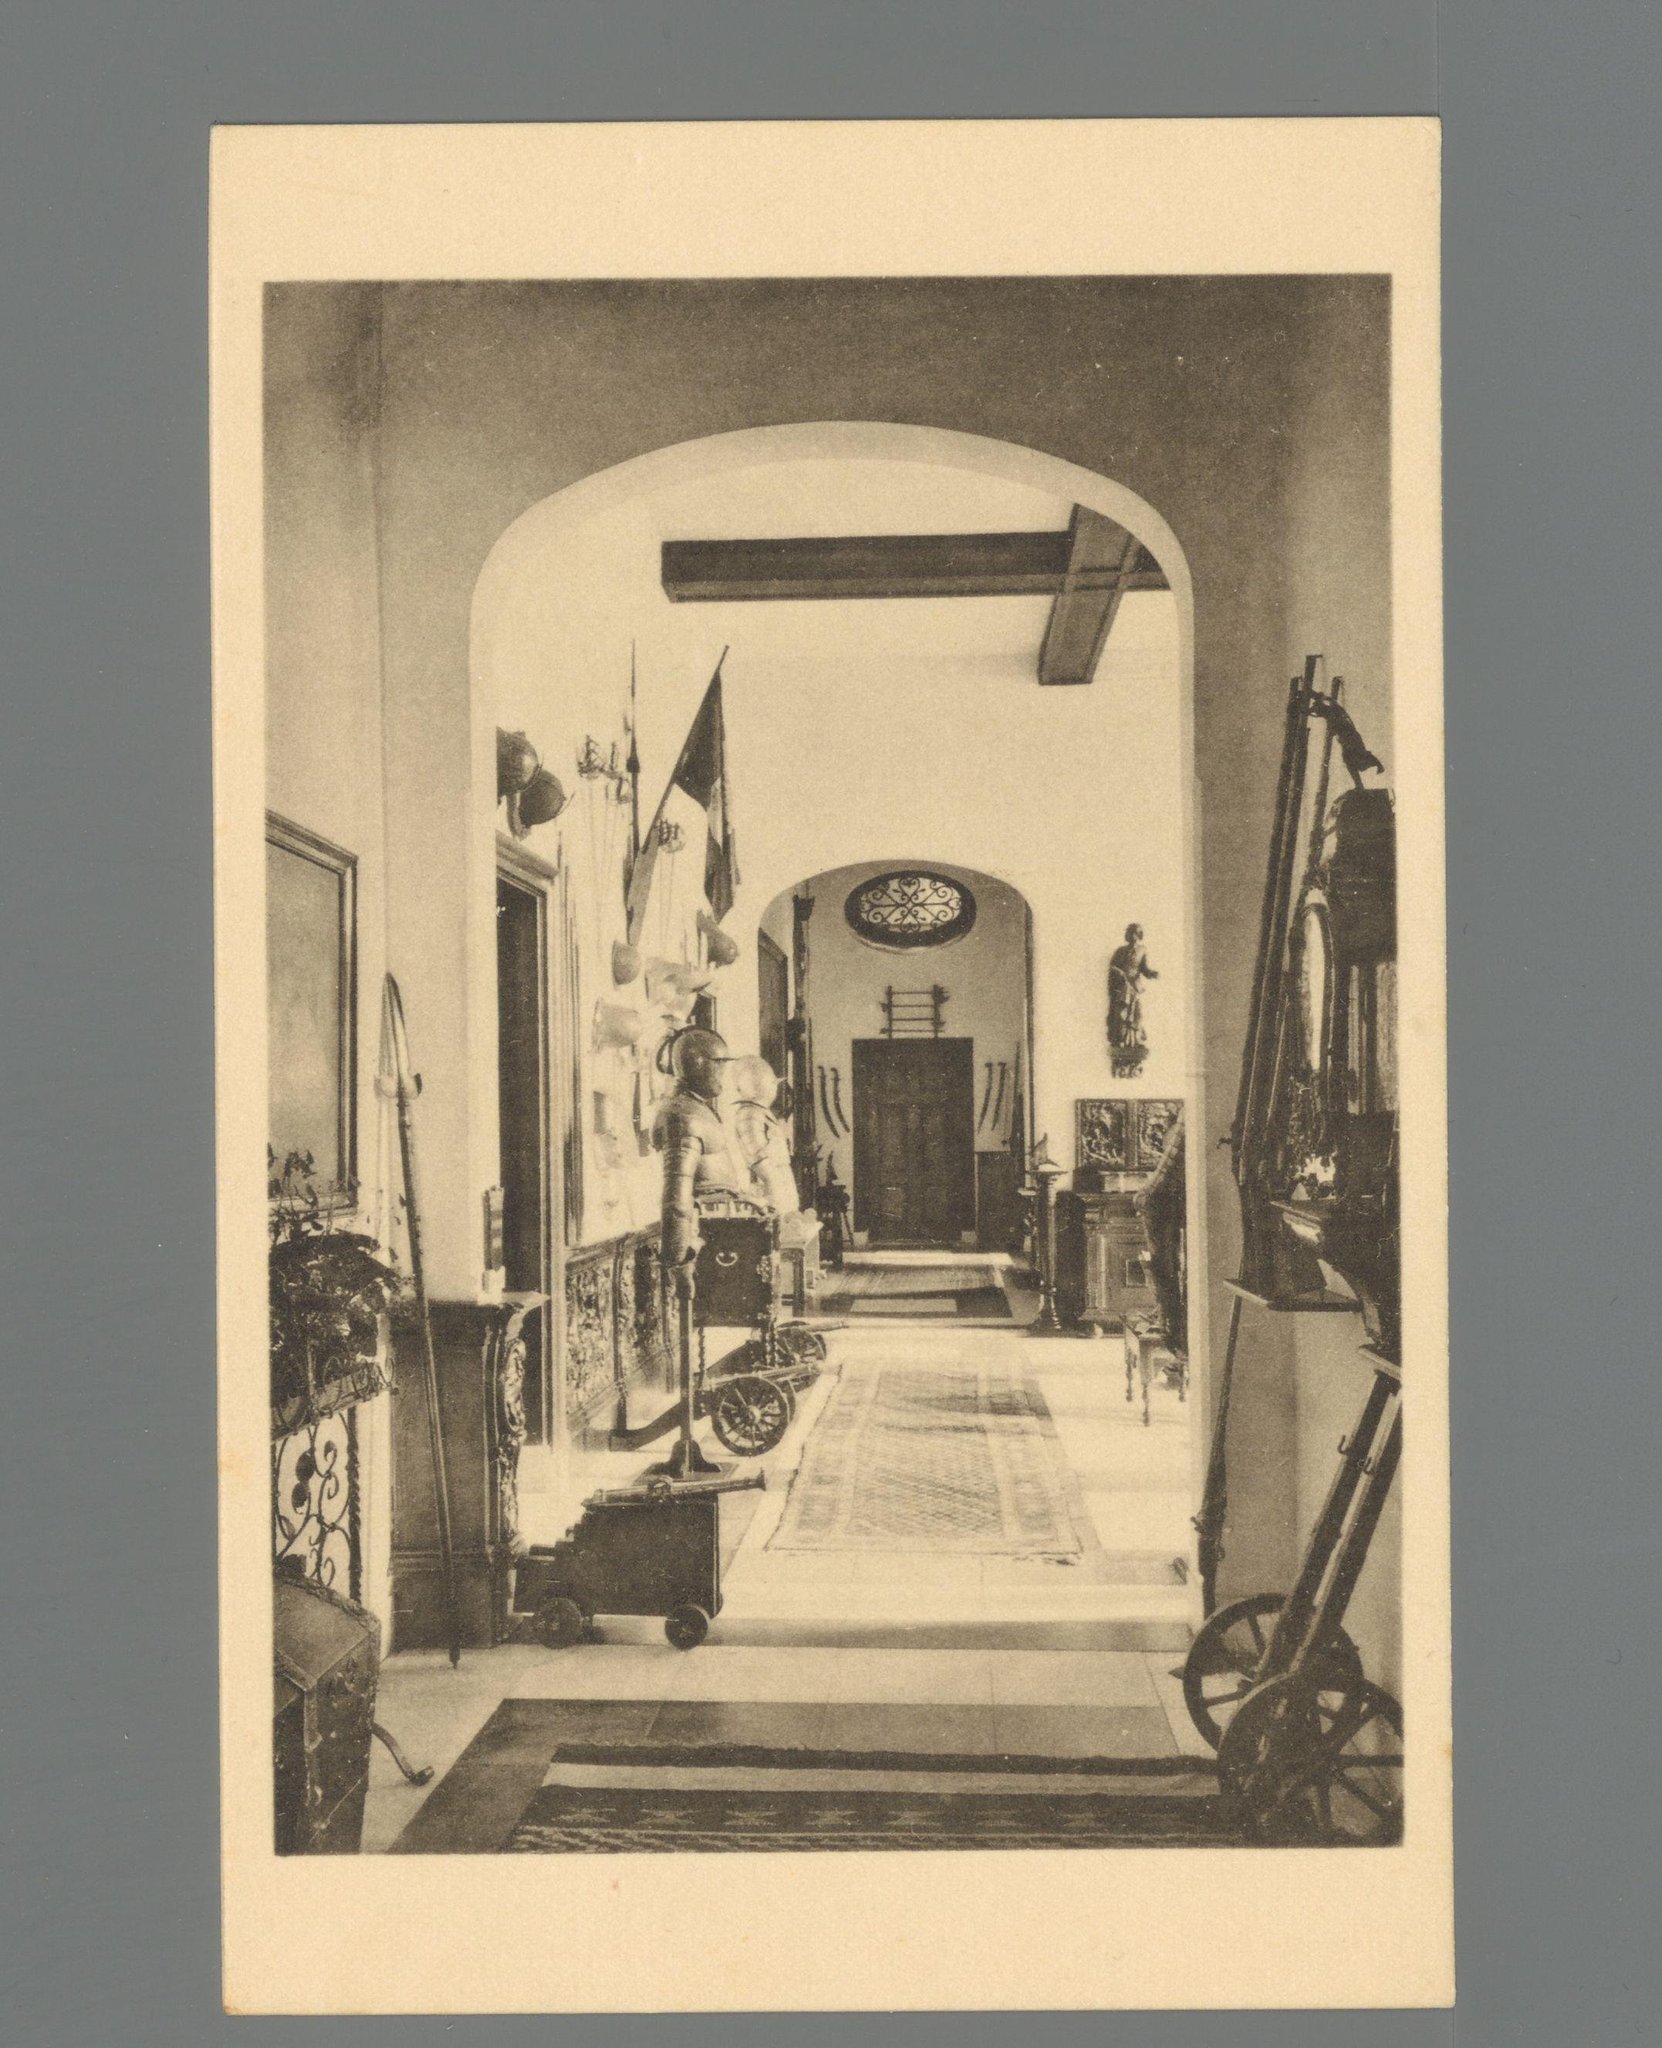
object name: ansichtkaart, prentbriefkaart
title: De Zonheuvel: Gang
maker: Anonymous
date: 1913-1950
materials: cardboard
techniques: photograph, writing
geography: doorn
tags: corridor, villa